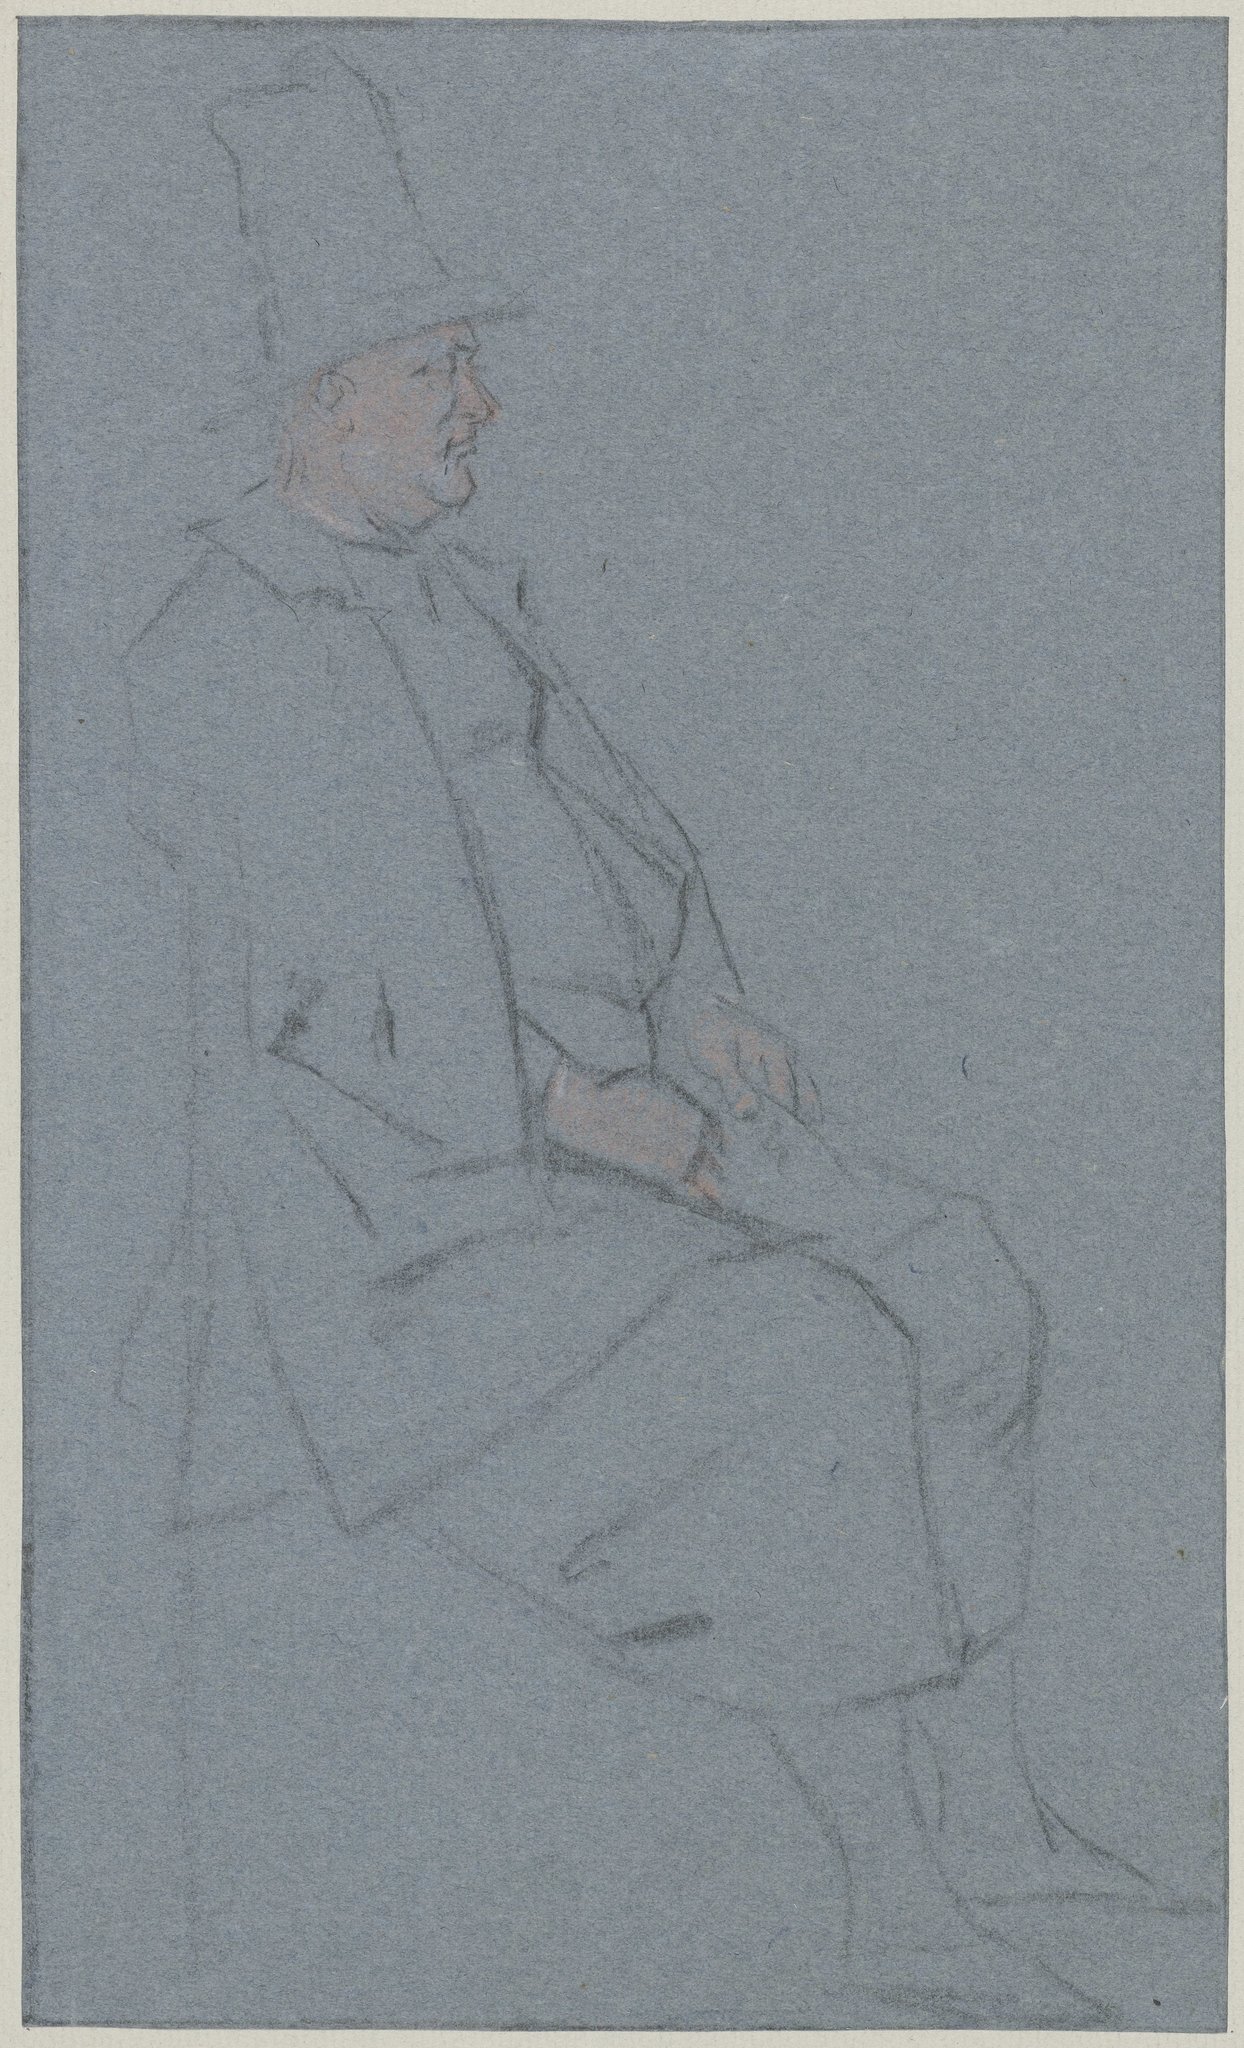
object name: drawing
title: Zittende kwaker, profiel naar rechts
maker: cornelis troost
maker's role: draughtsman, painter, print maker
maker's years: 1696-1750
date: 1706-1750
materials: chalk, paper, pastel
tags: (asselyn, jan claasz of de gewaande dienstmaagd) specific works of literature (with author, title), protestant churches and denominations (with name), comedy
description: Zittende kwaker, profiel naar rechts, met rechterhand gevouwen. Scène uit "Jan Claasz of de gewaande dienstmaagd" van Thomas Asselijn.